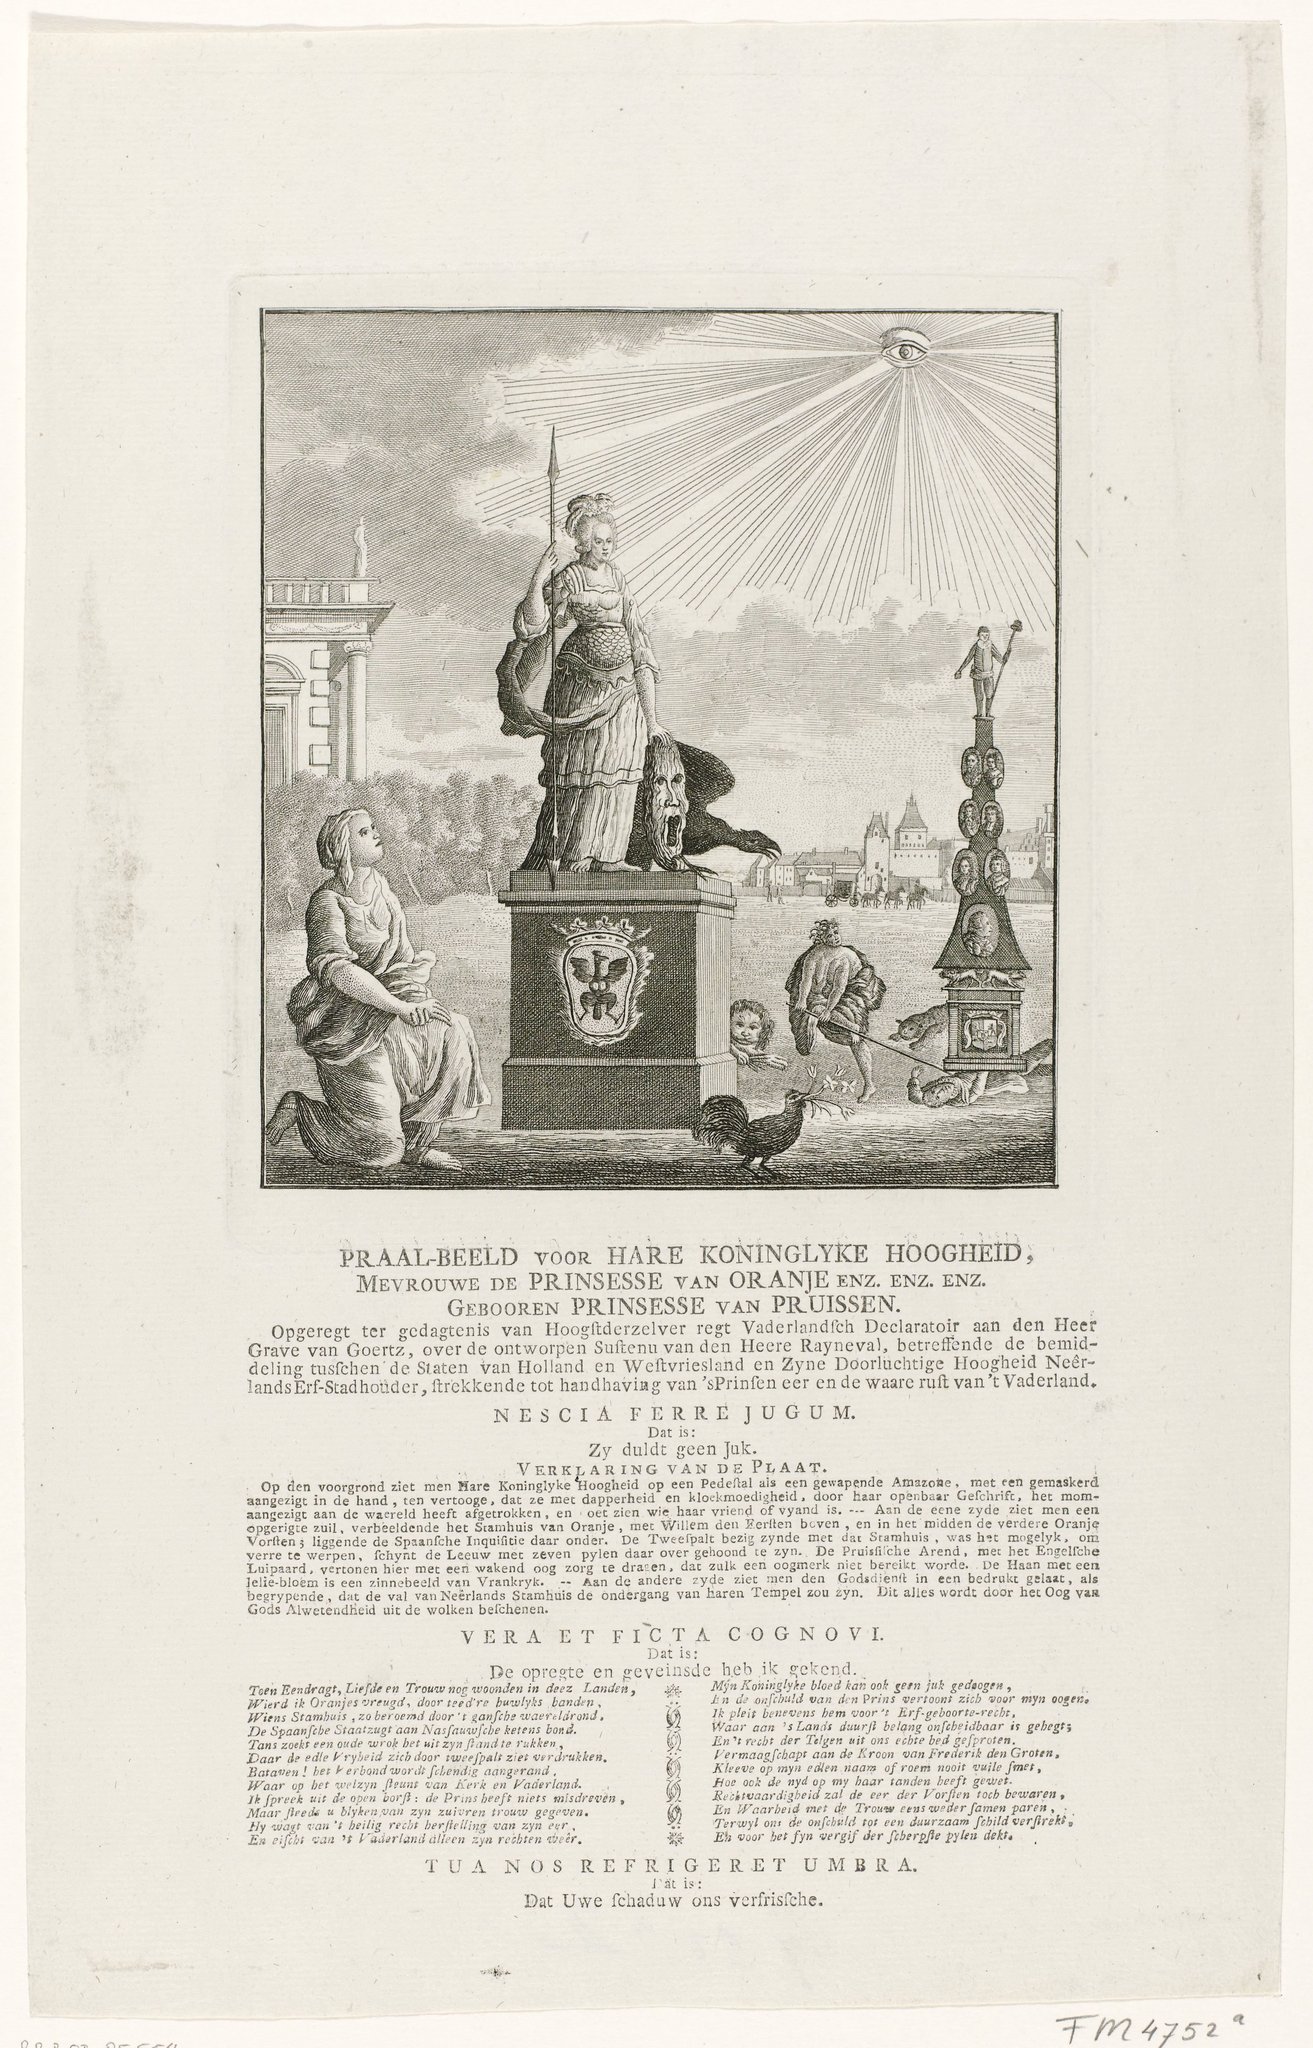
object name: print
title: Standbeeld voor Wilhelmina van Pruisen, 1786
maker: Anonymous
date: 1786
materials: paper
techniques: engraving, etching, letterpress printing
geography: northern netherlands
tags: berlin, draughtsman, wilhelmina of prussia (princess of orange), monument, statue, the all-seeing eye, triangle with eye ~ symbol of god the father, homage to a ruler, patriots (1780-1795)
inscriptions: collector's mark: Lugt 2228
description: Allegrorisch standbeeld ter ere van van prinses Wilhelmina van Pruisen, naar aanleiding van de bemiddeling tussen de Staten van Holland en West-Friesland en de erfstadhouder, 1786. Beeld van de prinses als een gewapende Amazone. Rechts een monument met de vorsten uit het stamhuis van Oranje, links knielt de Godsdienst. In de hemel het Alziende Oog. Op het blad onder de plaat een verklaring van de voorstelling en een vers in twee kolommen. Bij de plaat behoort een pendant.